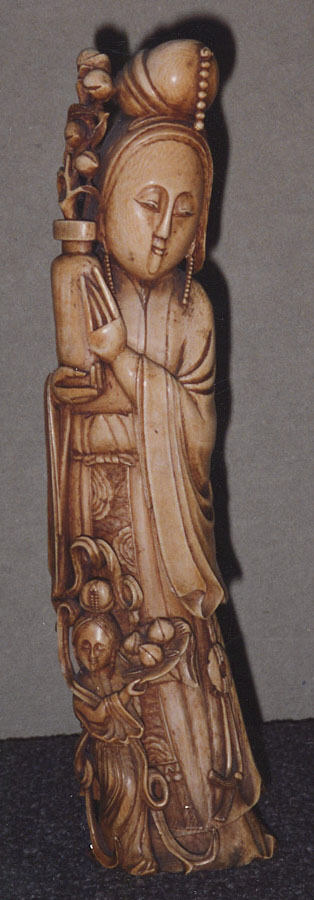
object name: figure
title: Statuette of Female Diety with Female Attendant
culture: chinese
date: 1901-2000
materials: ivory